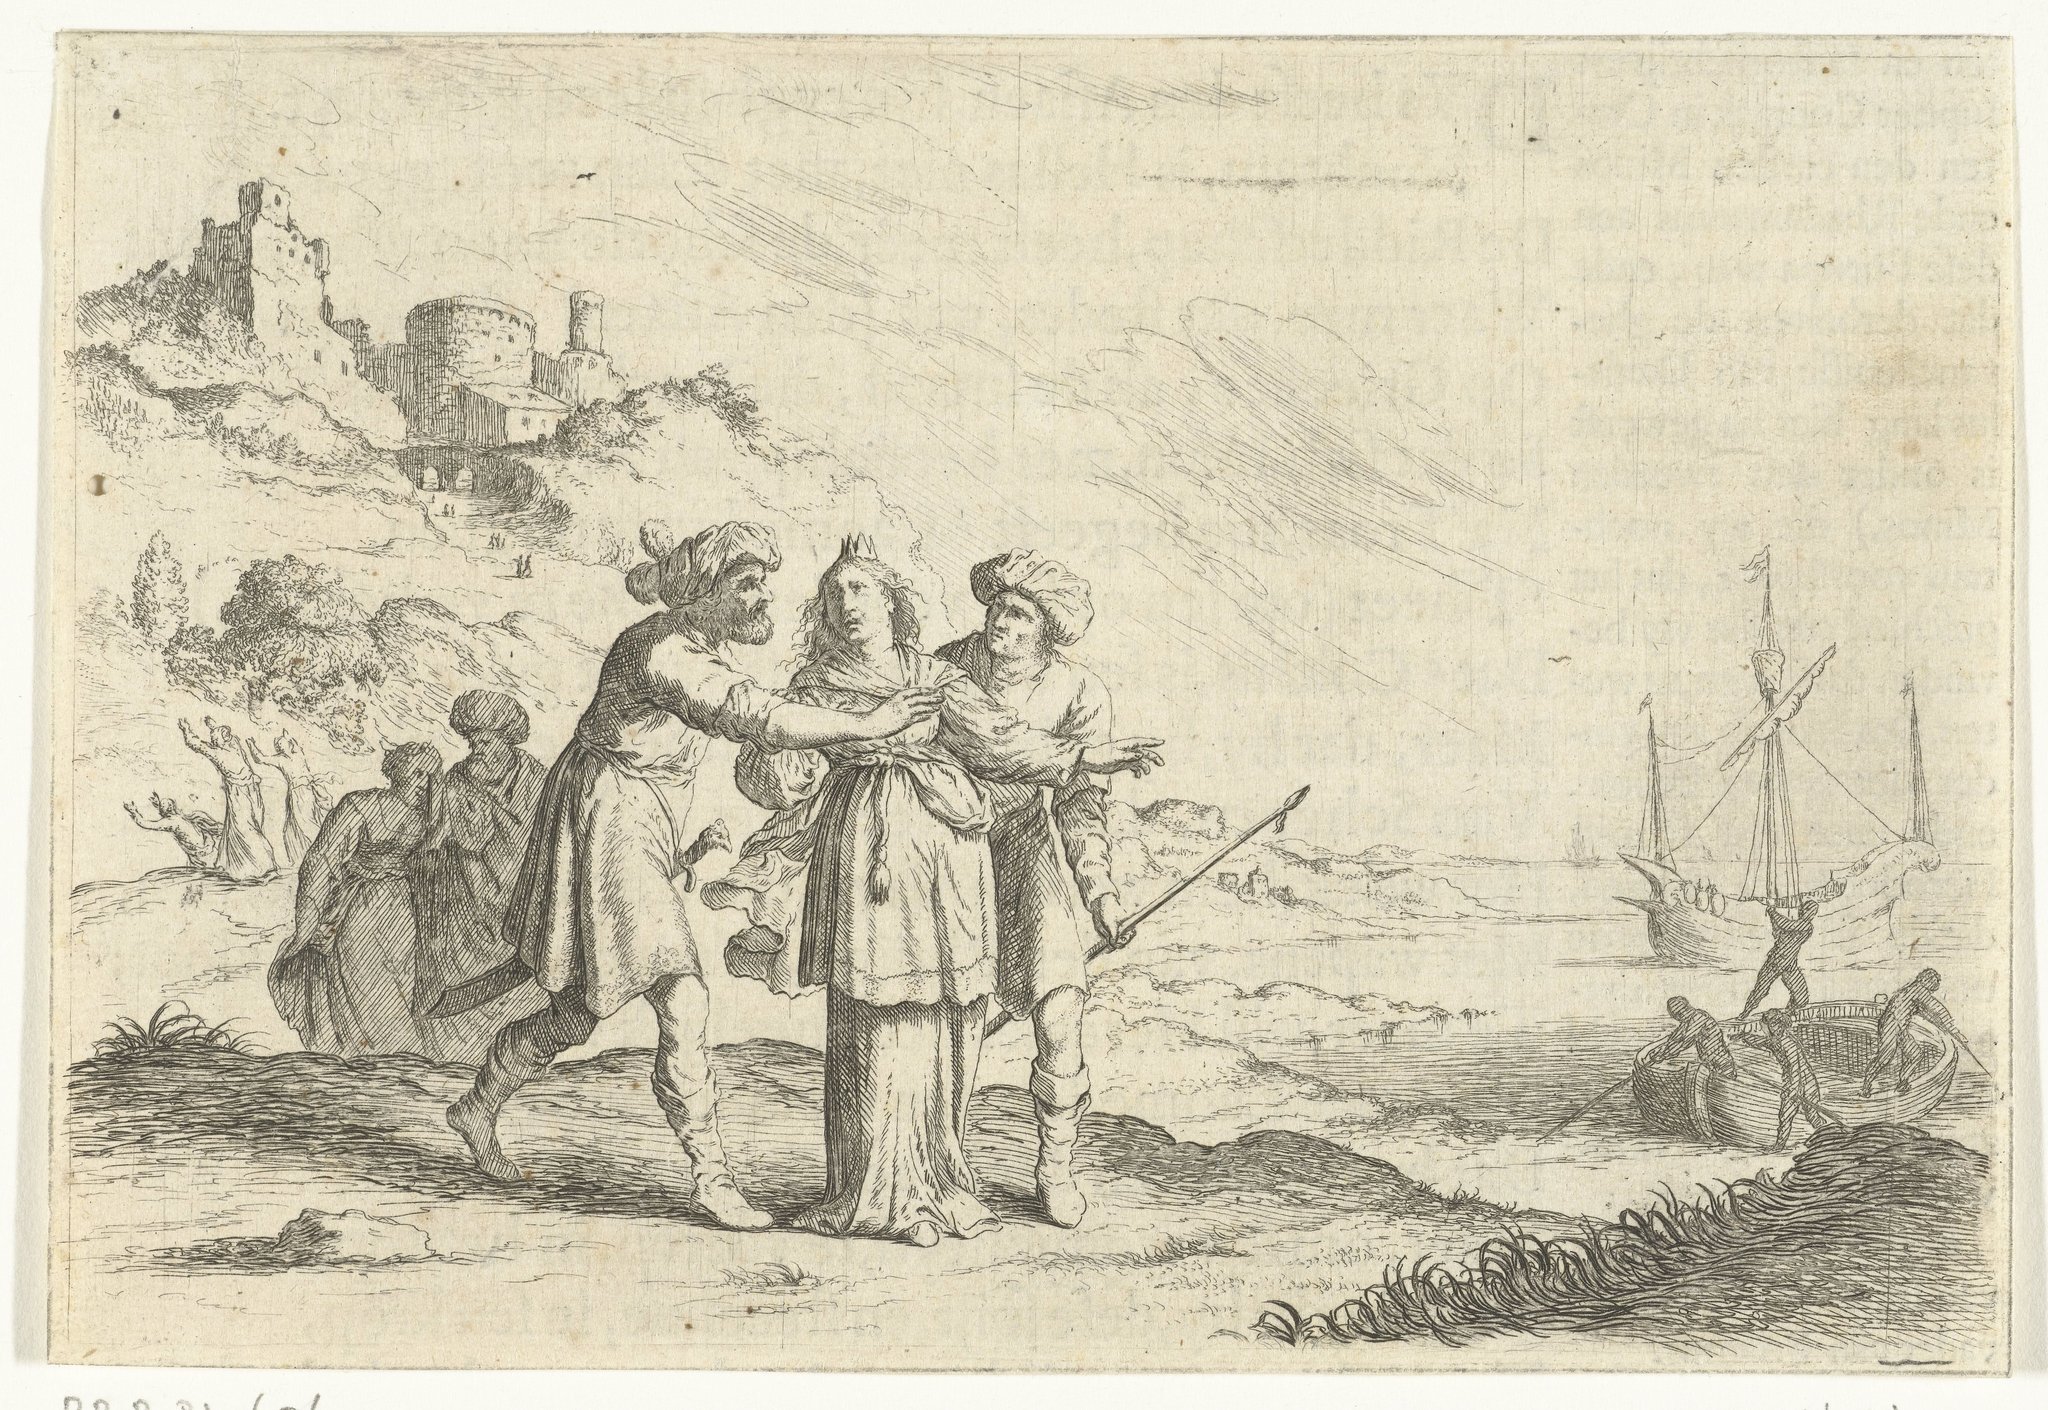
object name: print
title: Ontvoering van de dochter van de koning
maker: willem basse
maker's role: draughtsman, print maker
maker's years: 1613-1672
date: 1632-1634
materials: paper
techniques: engraving, etching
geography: northern netherlands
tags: man abducting woman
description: De ontvoering van de dochter van de Griekse koning Inachus door de Phoeniciër naar Egypte. Bedrukt op achterzijde met tekst in het Nederlands.